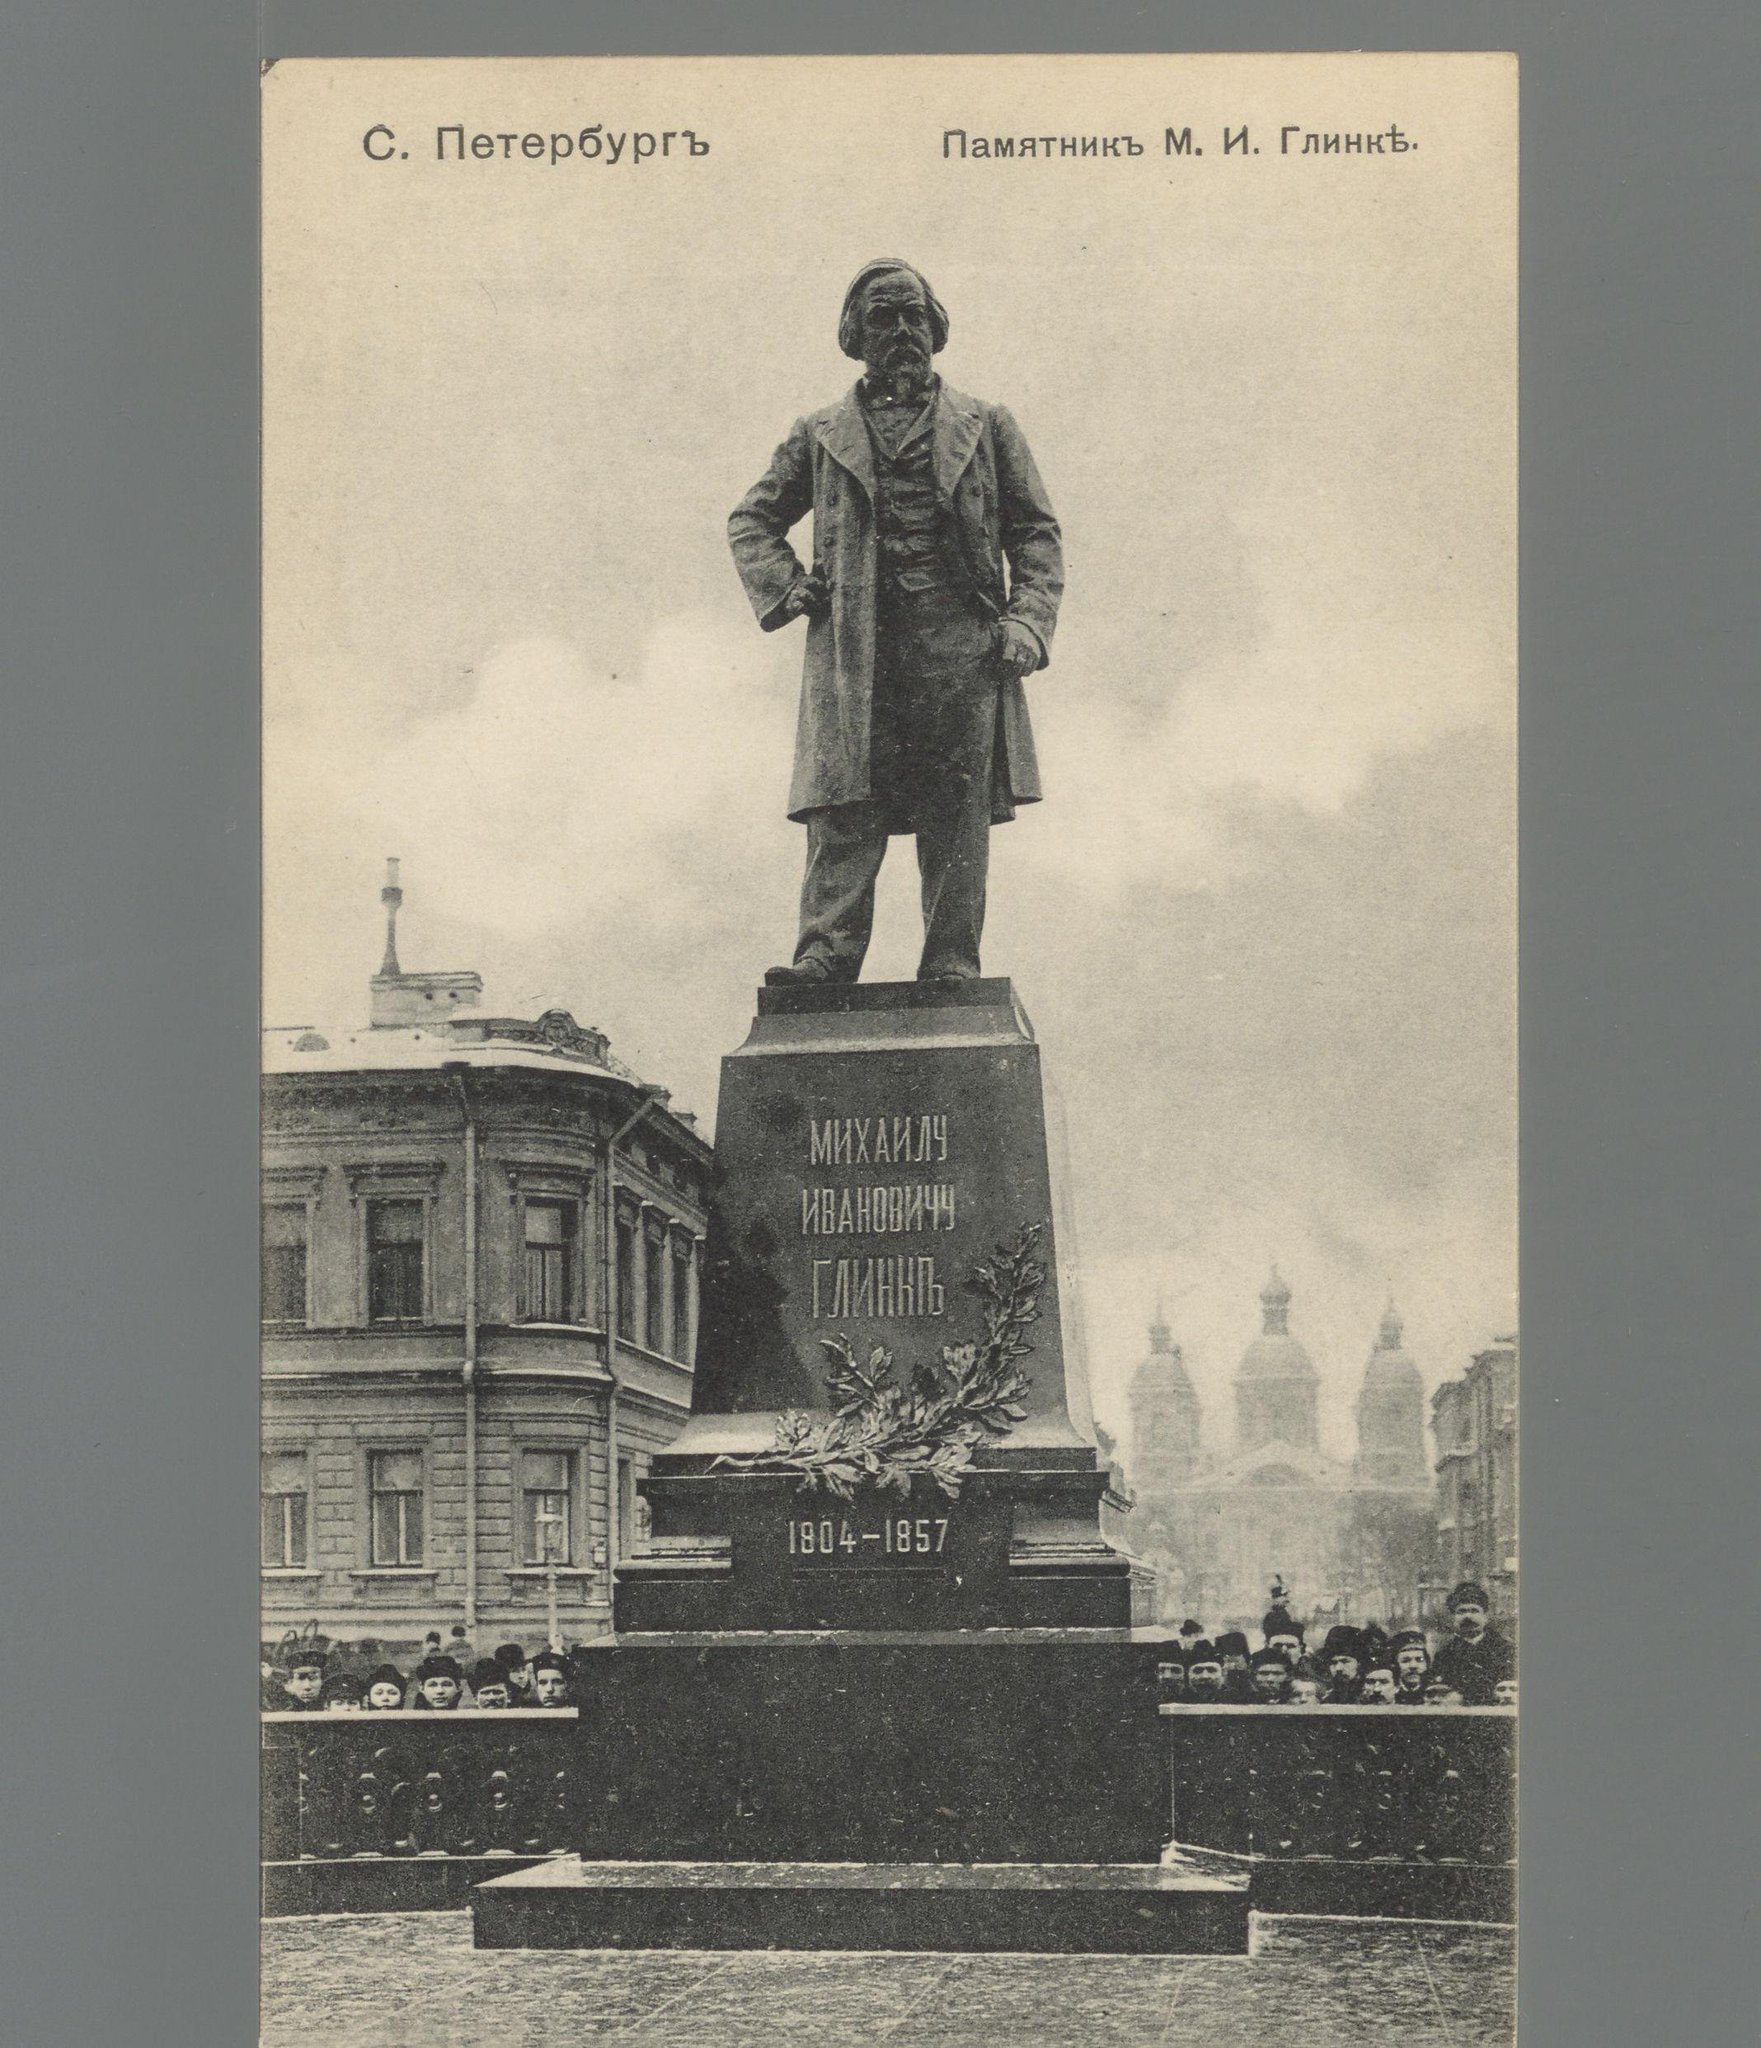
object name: photomechanical print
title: Gezicht op het monument voor componist Mikhail Glinka te Sint-Petersburg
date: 1906-1930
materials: cardboard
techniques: photograph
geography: sint-petersburg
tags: berlin, monument, statue, composer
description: Titel op object staat op recto in het Russisch.